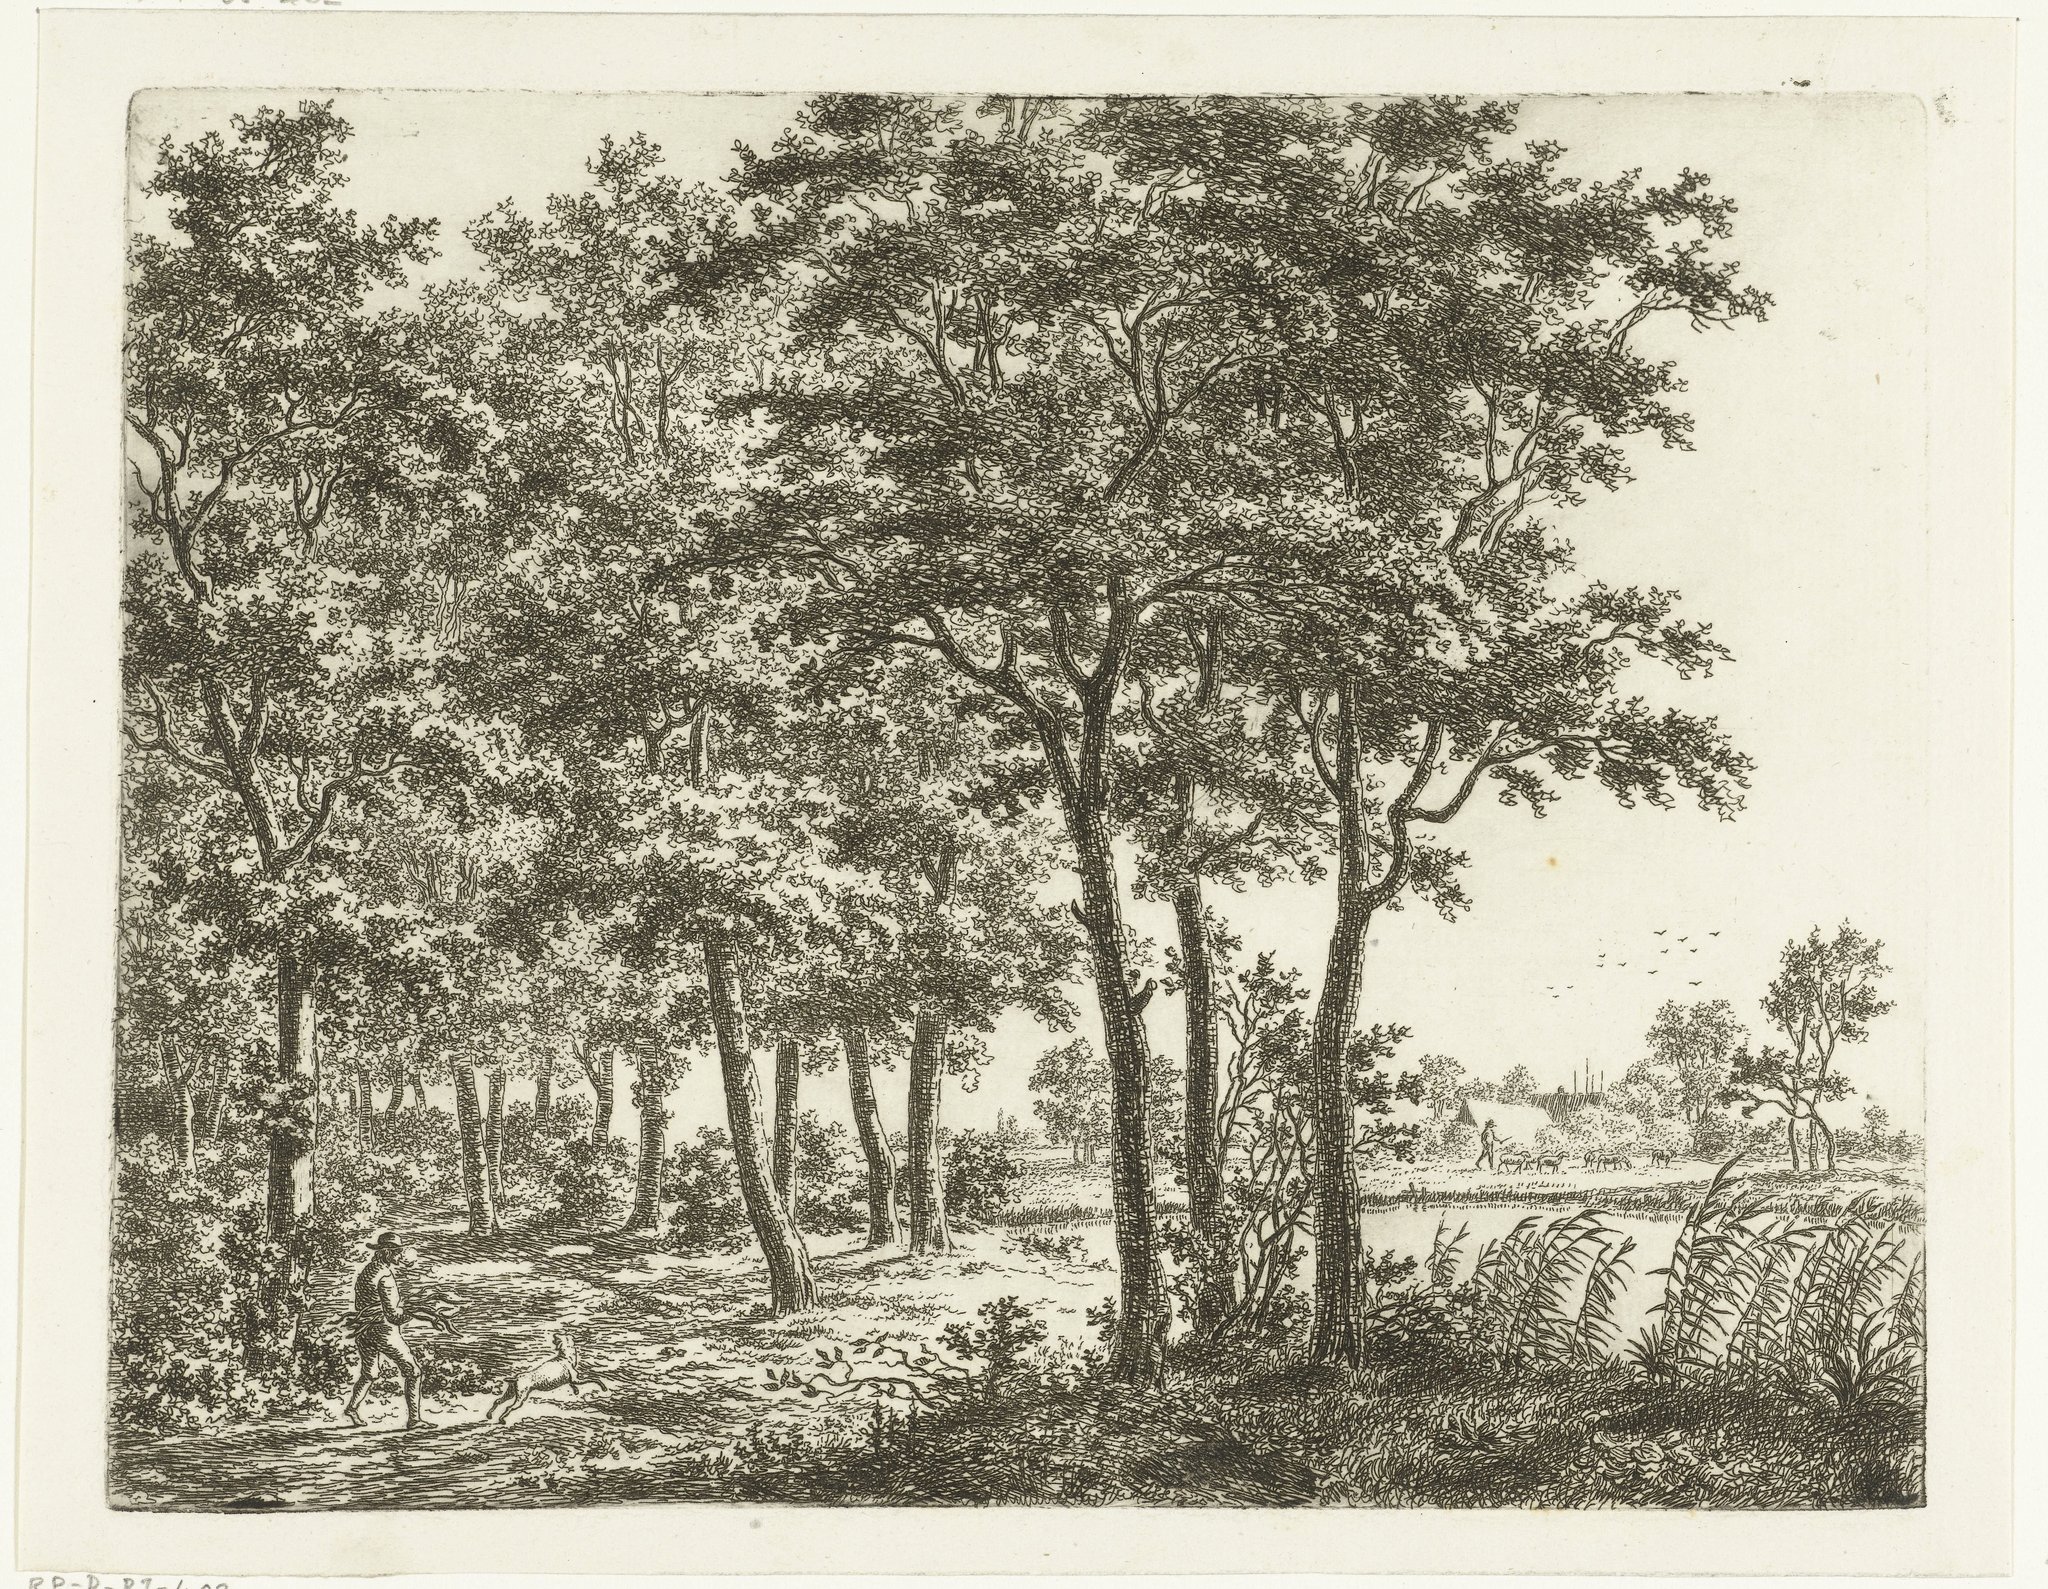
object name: print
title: Landschap met hond en man die een takkenbos draagt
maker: ernst willem jan bagelaar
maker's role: draughtsman, print maker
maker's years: 1775-1837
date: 1798-1837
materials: paper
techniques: etching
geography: netherlands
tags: landscapes in the temperate zone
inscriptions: collector's mark: Lugt 2228